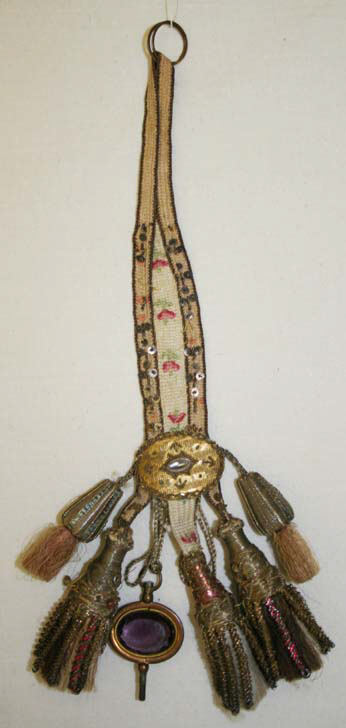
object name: fob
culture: european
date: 1767-1800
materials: glass, linen, metal, silk